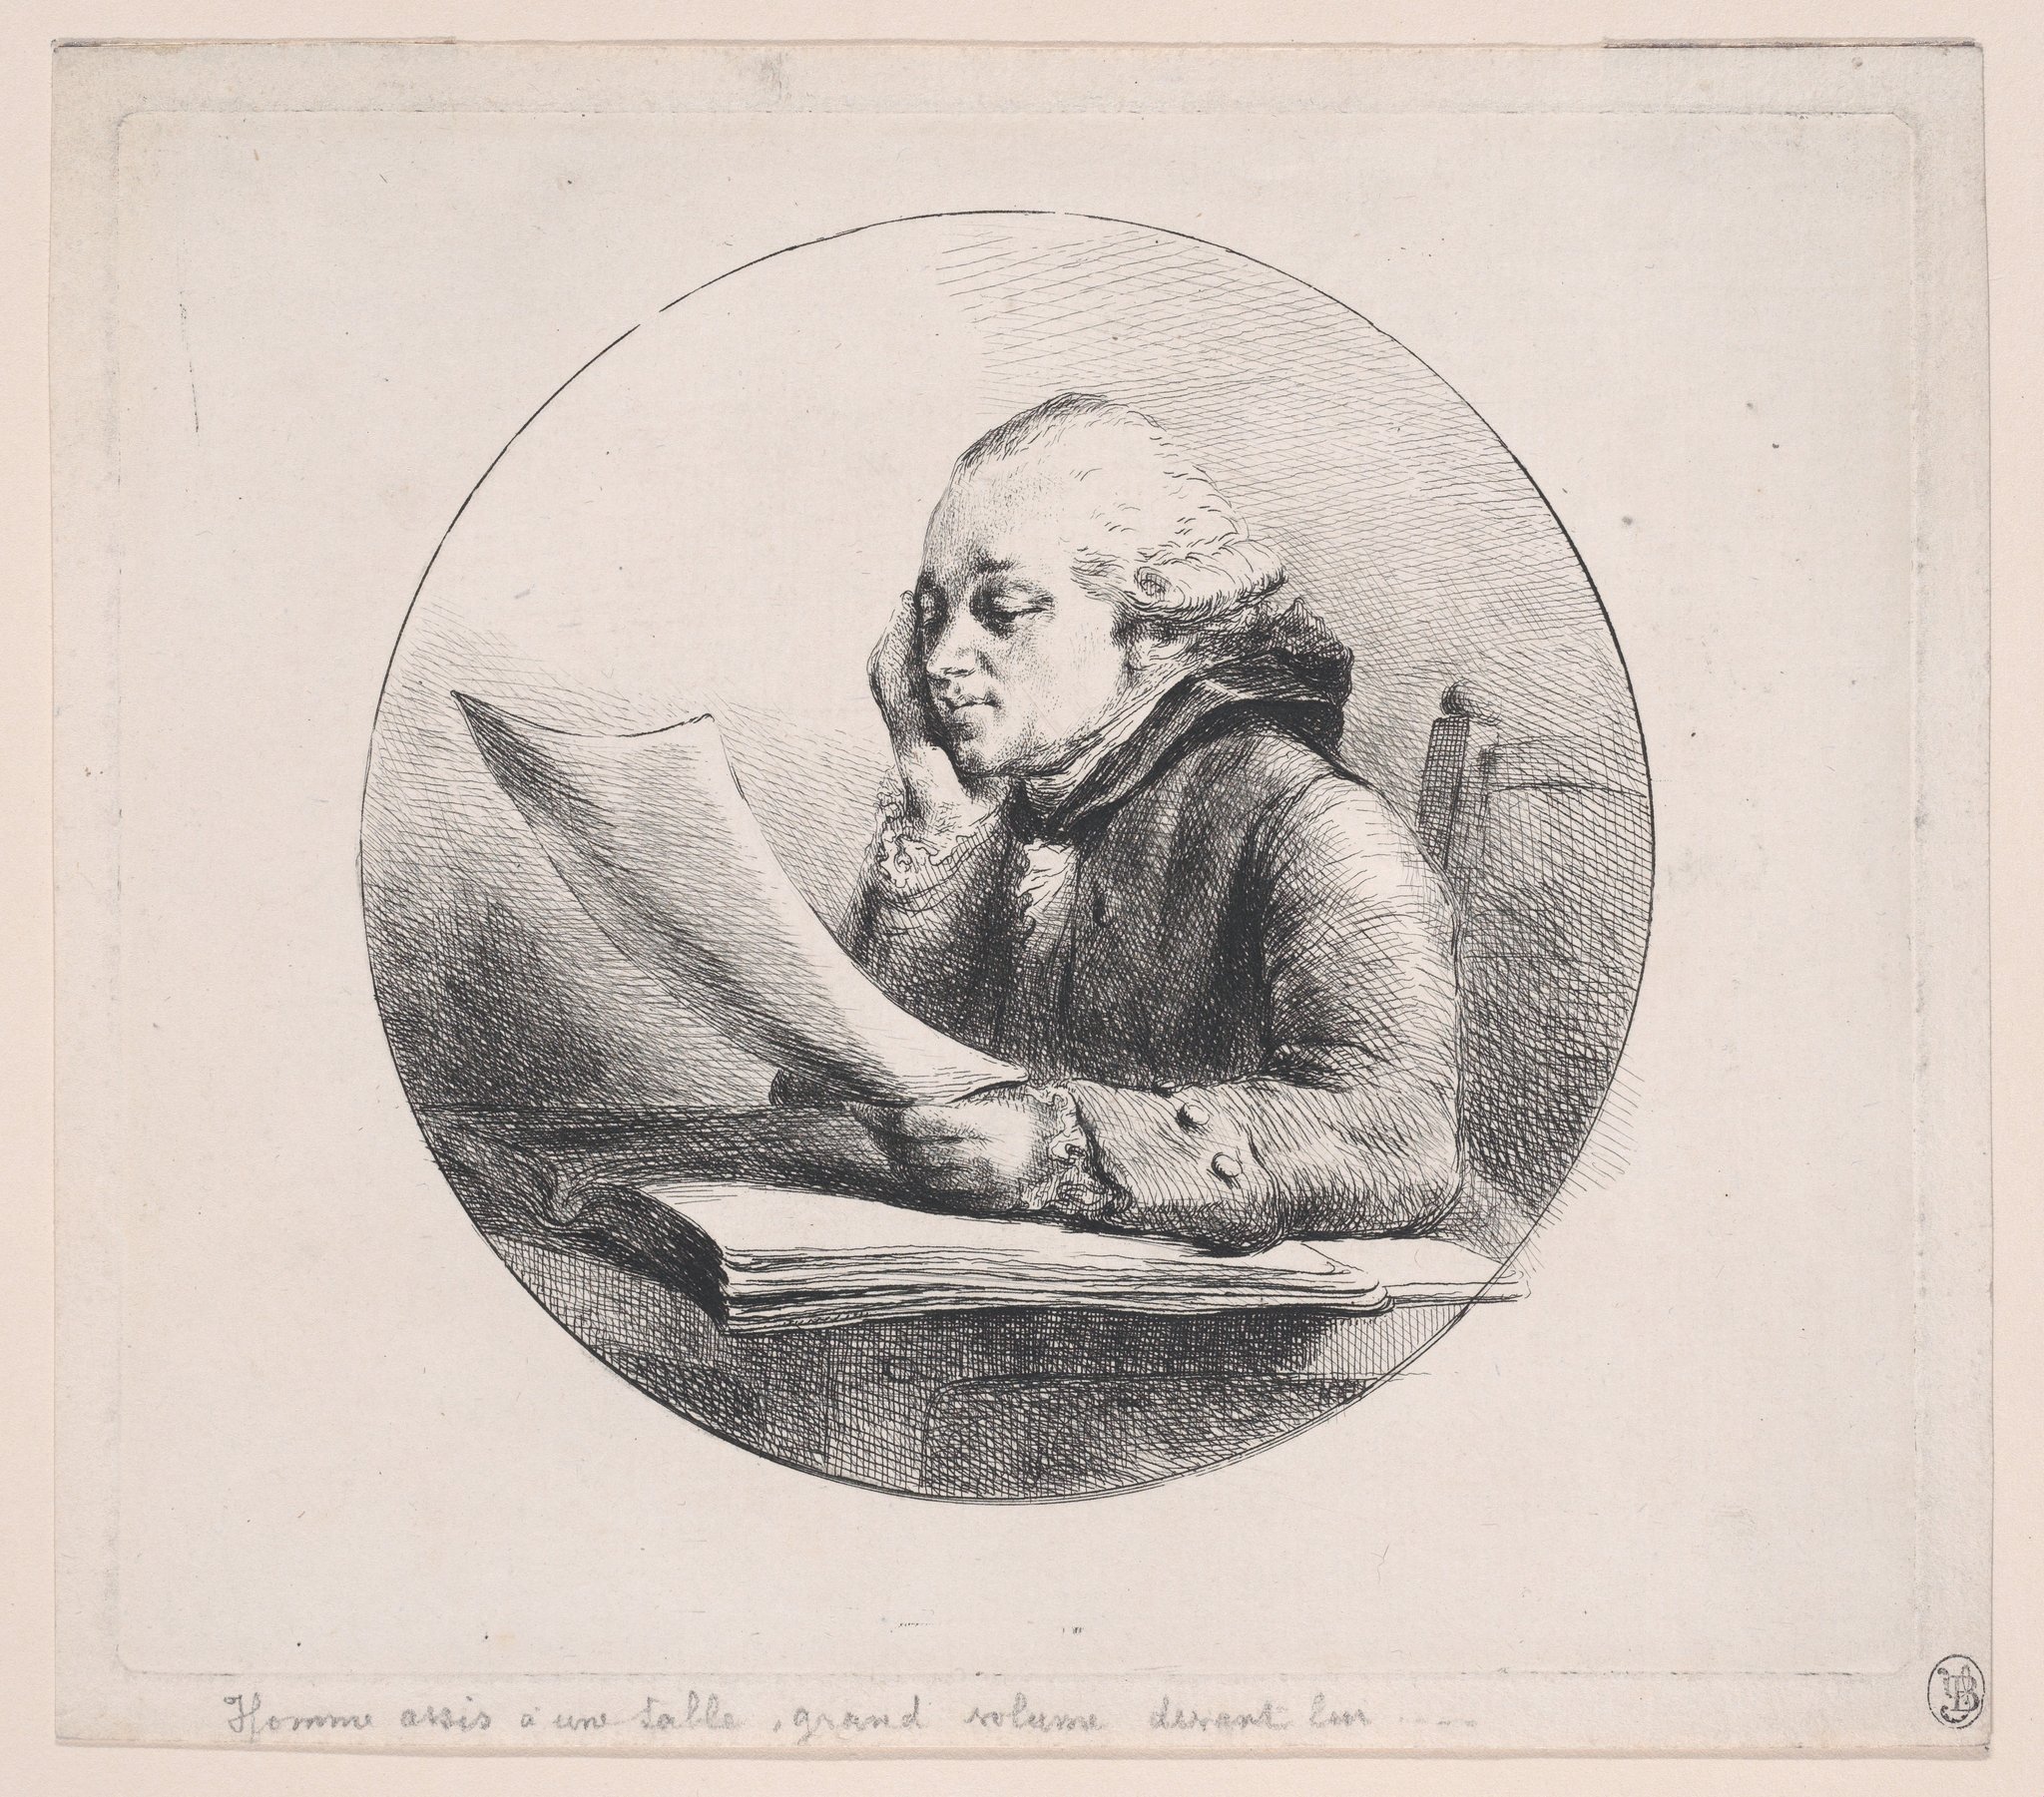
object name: print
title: Portrait of a Man Reading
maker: baron dominique vivant denon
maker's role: artist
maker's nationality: french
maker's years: 1747-1825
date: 1701-1833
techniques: etching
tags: men,portraits,reading